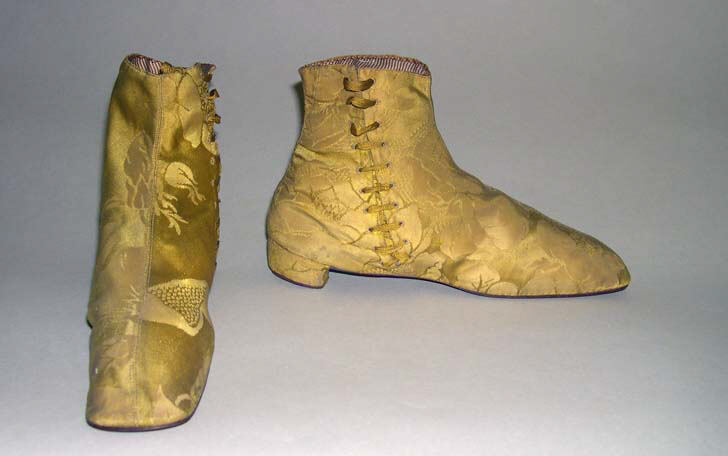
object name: shoe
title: Shoes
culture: american or european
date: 1850-1859